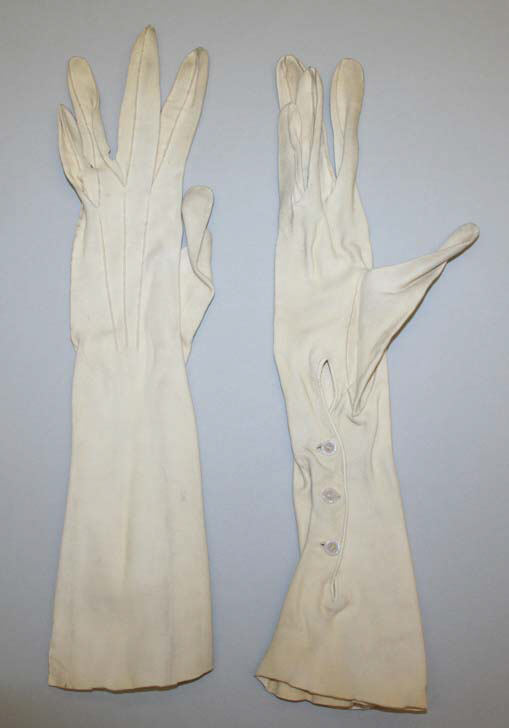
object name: glove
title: Gloves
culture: french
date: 1894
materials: leather